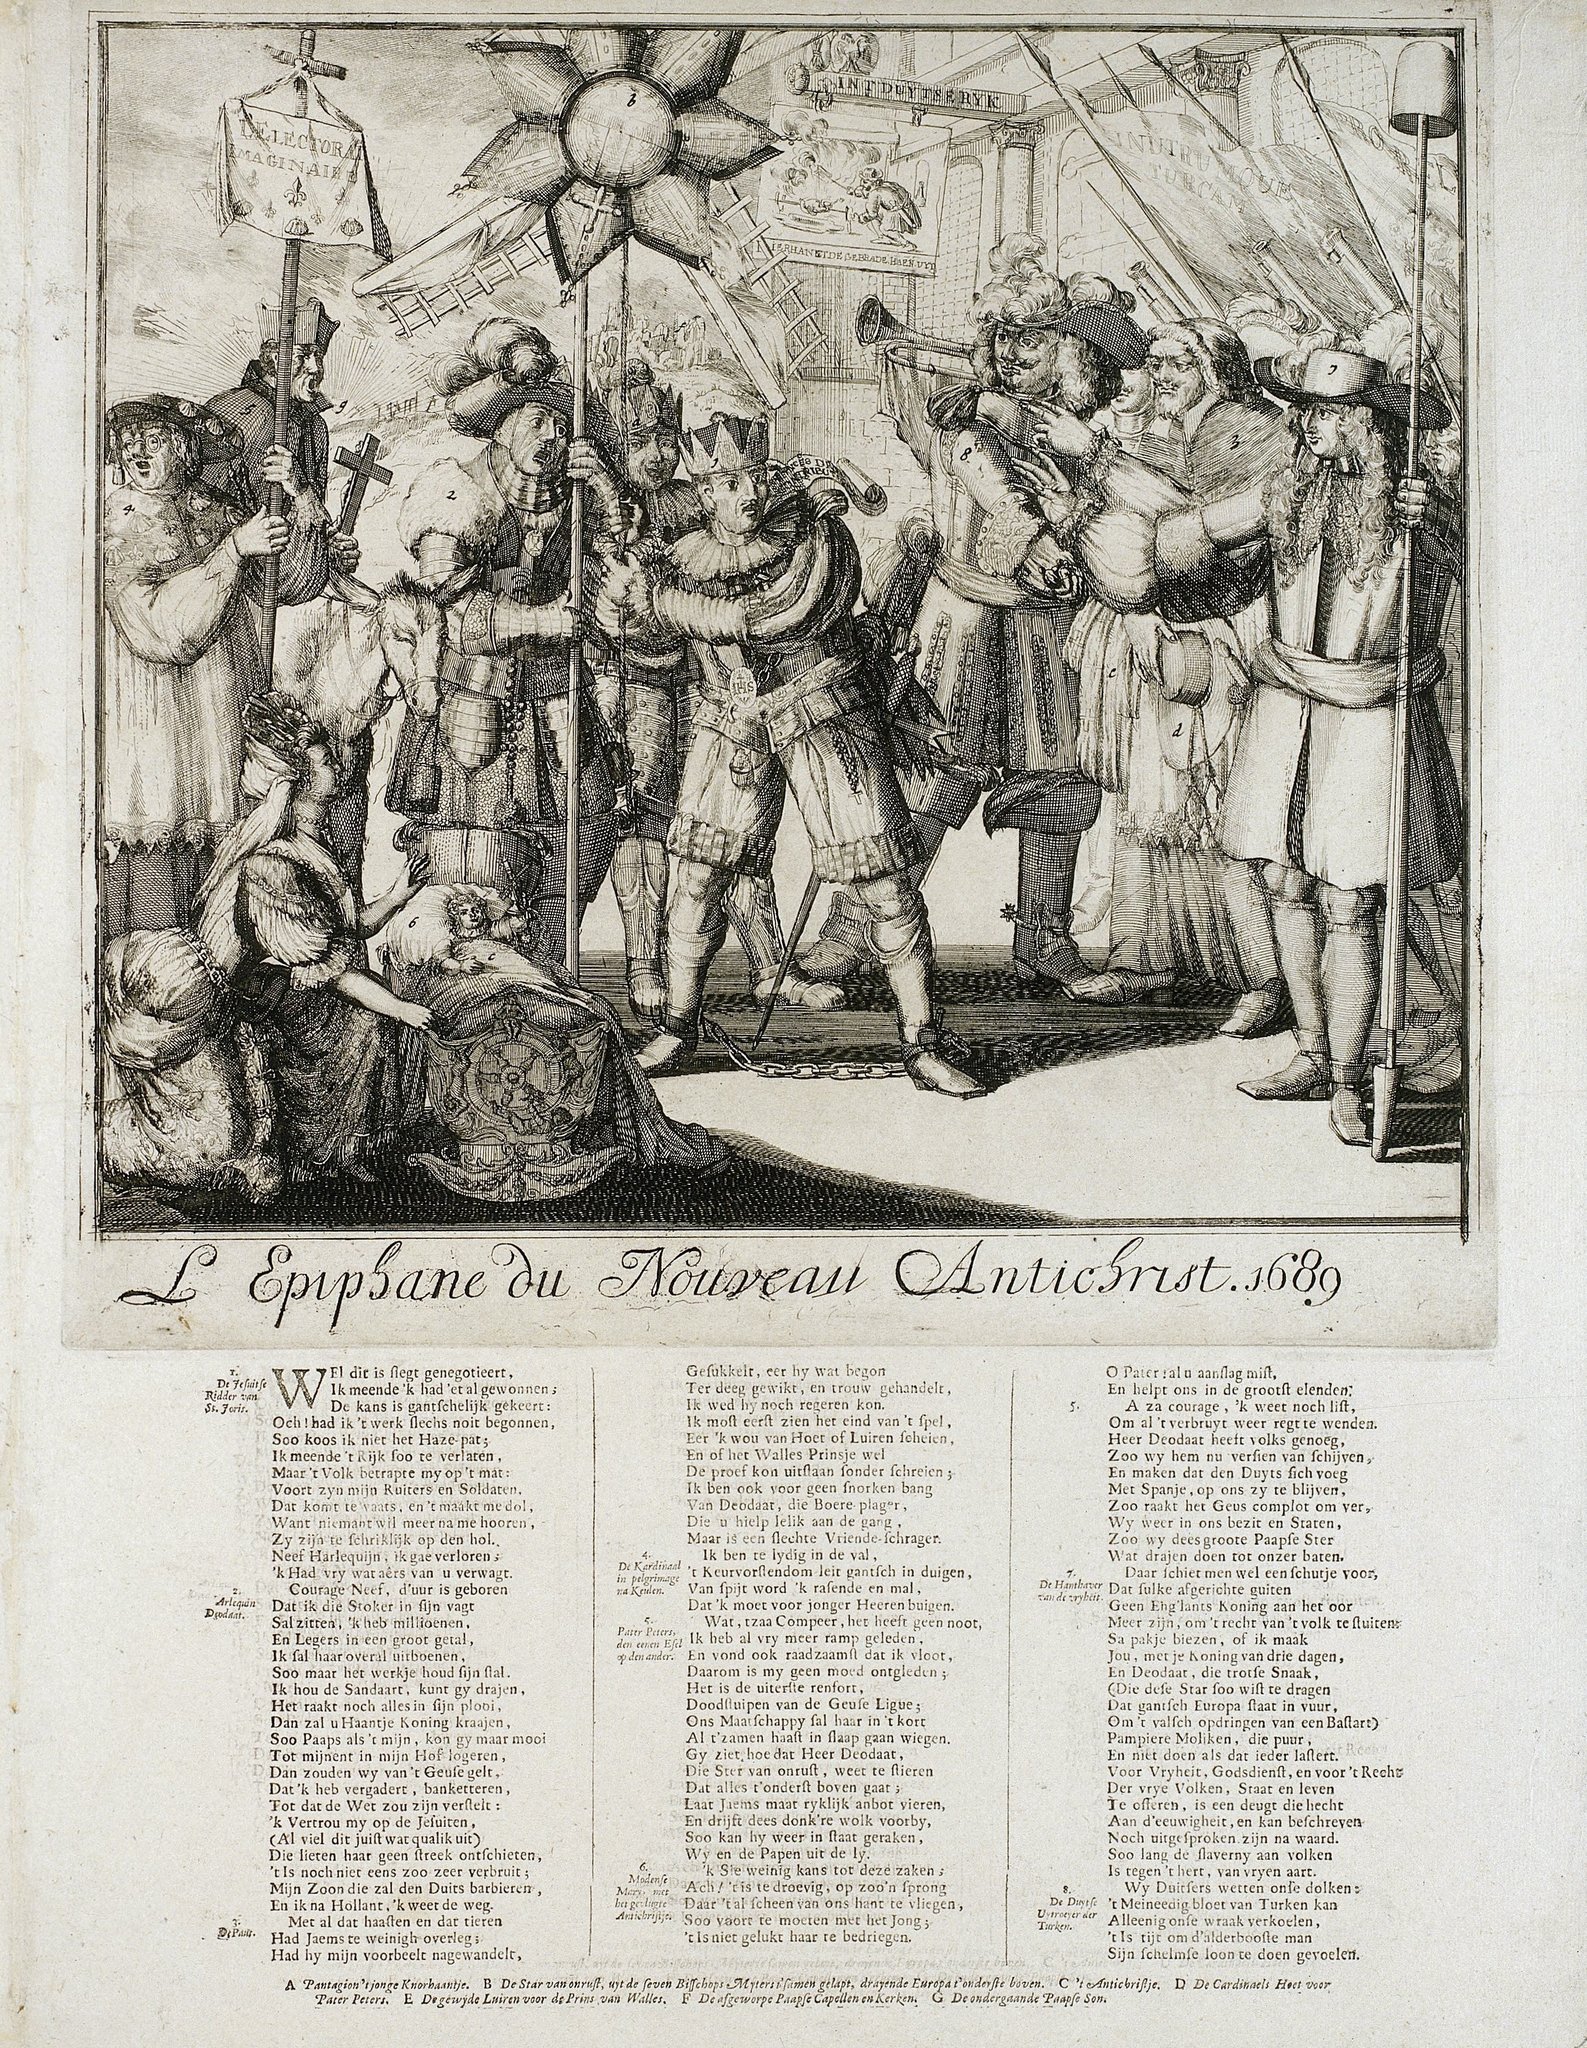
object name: cartoon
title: Spotprenten op Jacobus II en Lodewijk XIV en de gebeurtenissen in de jaren 1688-1689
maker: romeyn de hooghe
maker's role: draughtsman, goldsmith, painter, print maker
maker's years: 1645-1708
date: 1689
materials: paper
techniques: engraving, etching, letterpress printing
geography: netherlands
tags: jacobus ii (koning van engeland en schotland), the hague, william iii (prince of orange and king of england, scotland, and ireland), lodewijk xiv (koning van frankrijk), venice, clergyman, alexander viii, leopold i (keizer van duitsland), dauphin van frankrijk lodewijk, london, rome, twelfth night, usually falling on the eve of january 6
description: Spotprent op de val van Jacobus II en zijn vlucht naar Frankrijk op 6 januari (Driekoningen), 1689. Jacobus II, Lodewijk XIV en de dauphin zingen op Driekoningen voor de paus, keizer Leopold I en Willem III. Links ook koningin Maria van Modena met het ondergeschoven kind, de kardinaal en pater Peters (Edward Petre) op een ezel. Onder de voorstelling een vers in 3 kolommen met een verklaring van de cijfers 1-8 in het Nederlands. Onderaan een verklaring van de letters A-G.